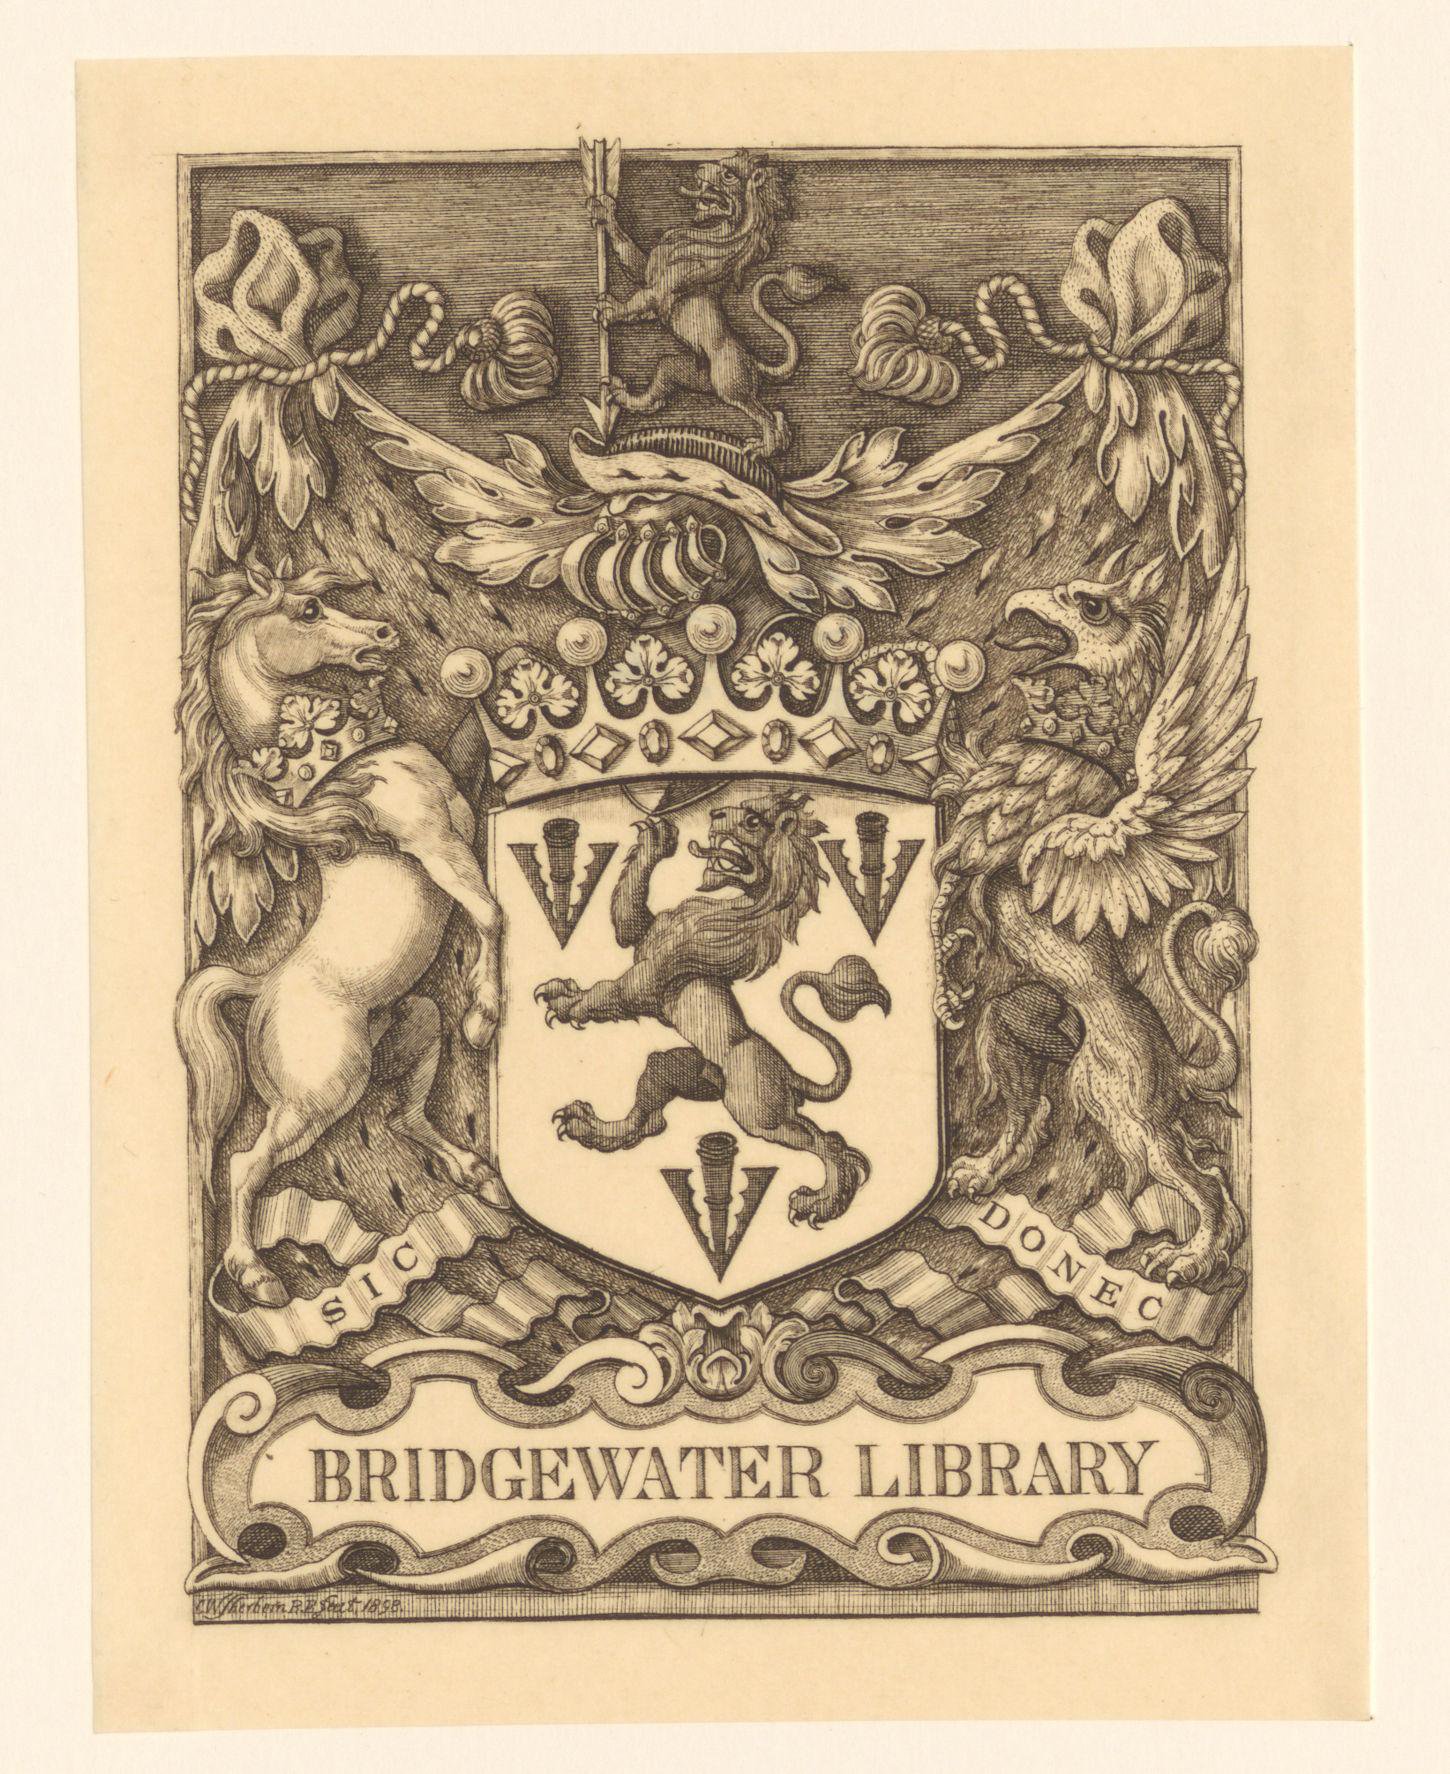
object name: bookplate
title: Ex libris van de Bridgewater Library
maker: charles william sherborn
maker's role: print maker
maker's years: 1831-1912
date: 1898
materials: paper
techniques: engraving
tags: foliage ~ ornament, horse, mis-shapen animals; monsters, armorial bearing, heraldry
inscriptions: collector's mark: Lugt 2228